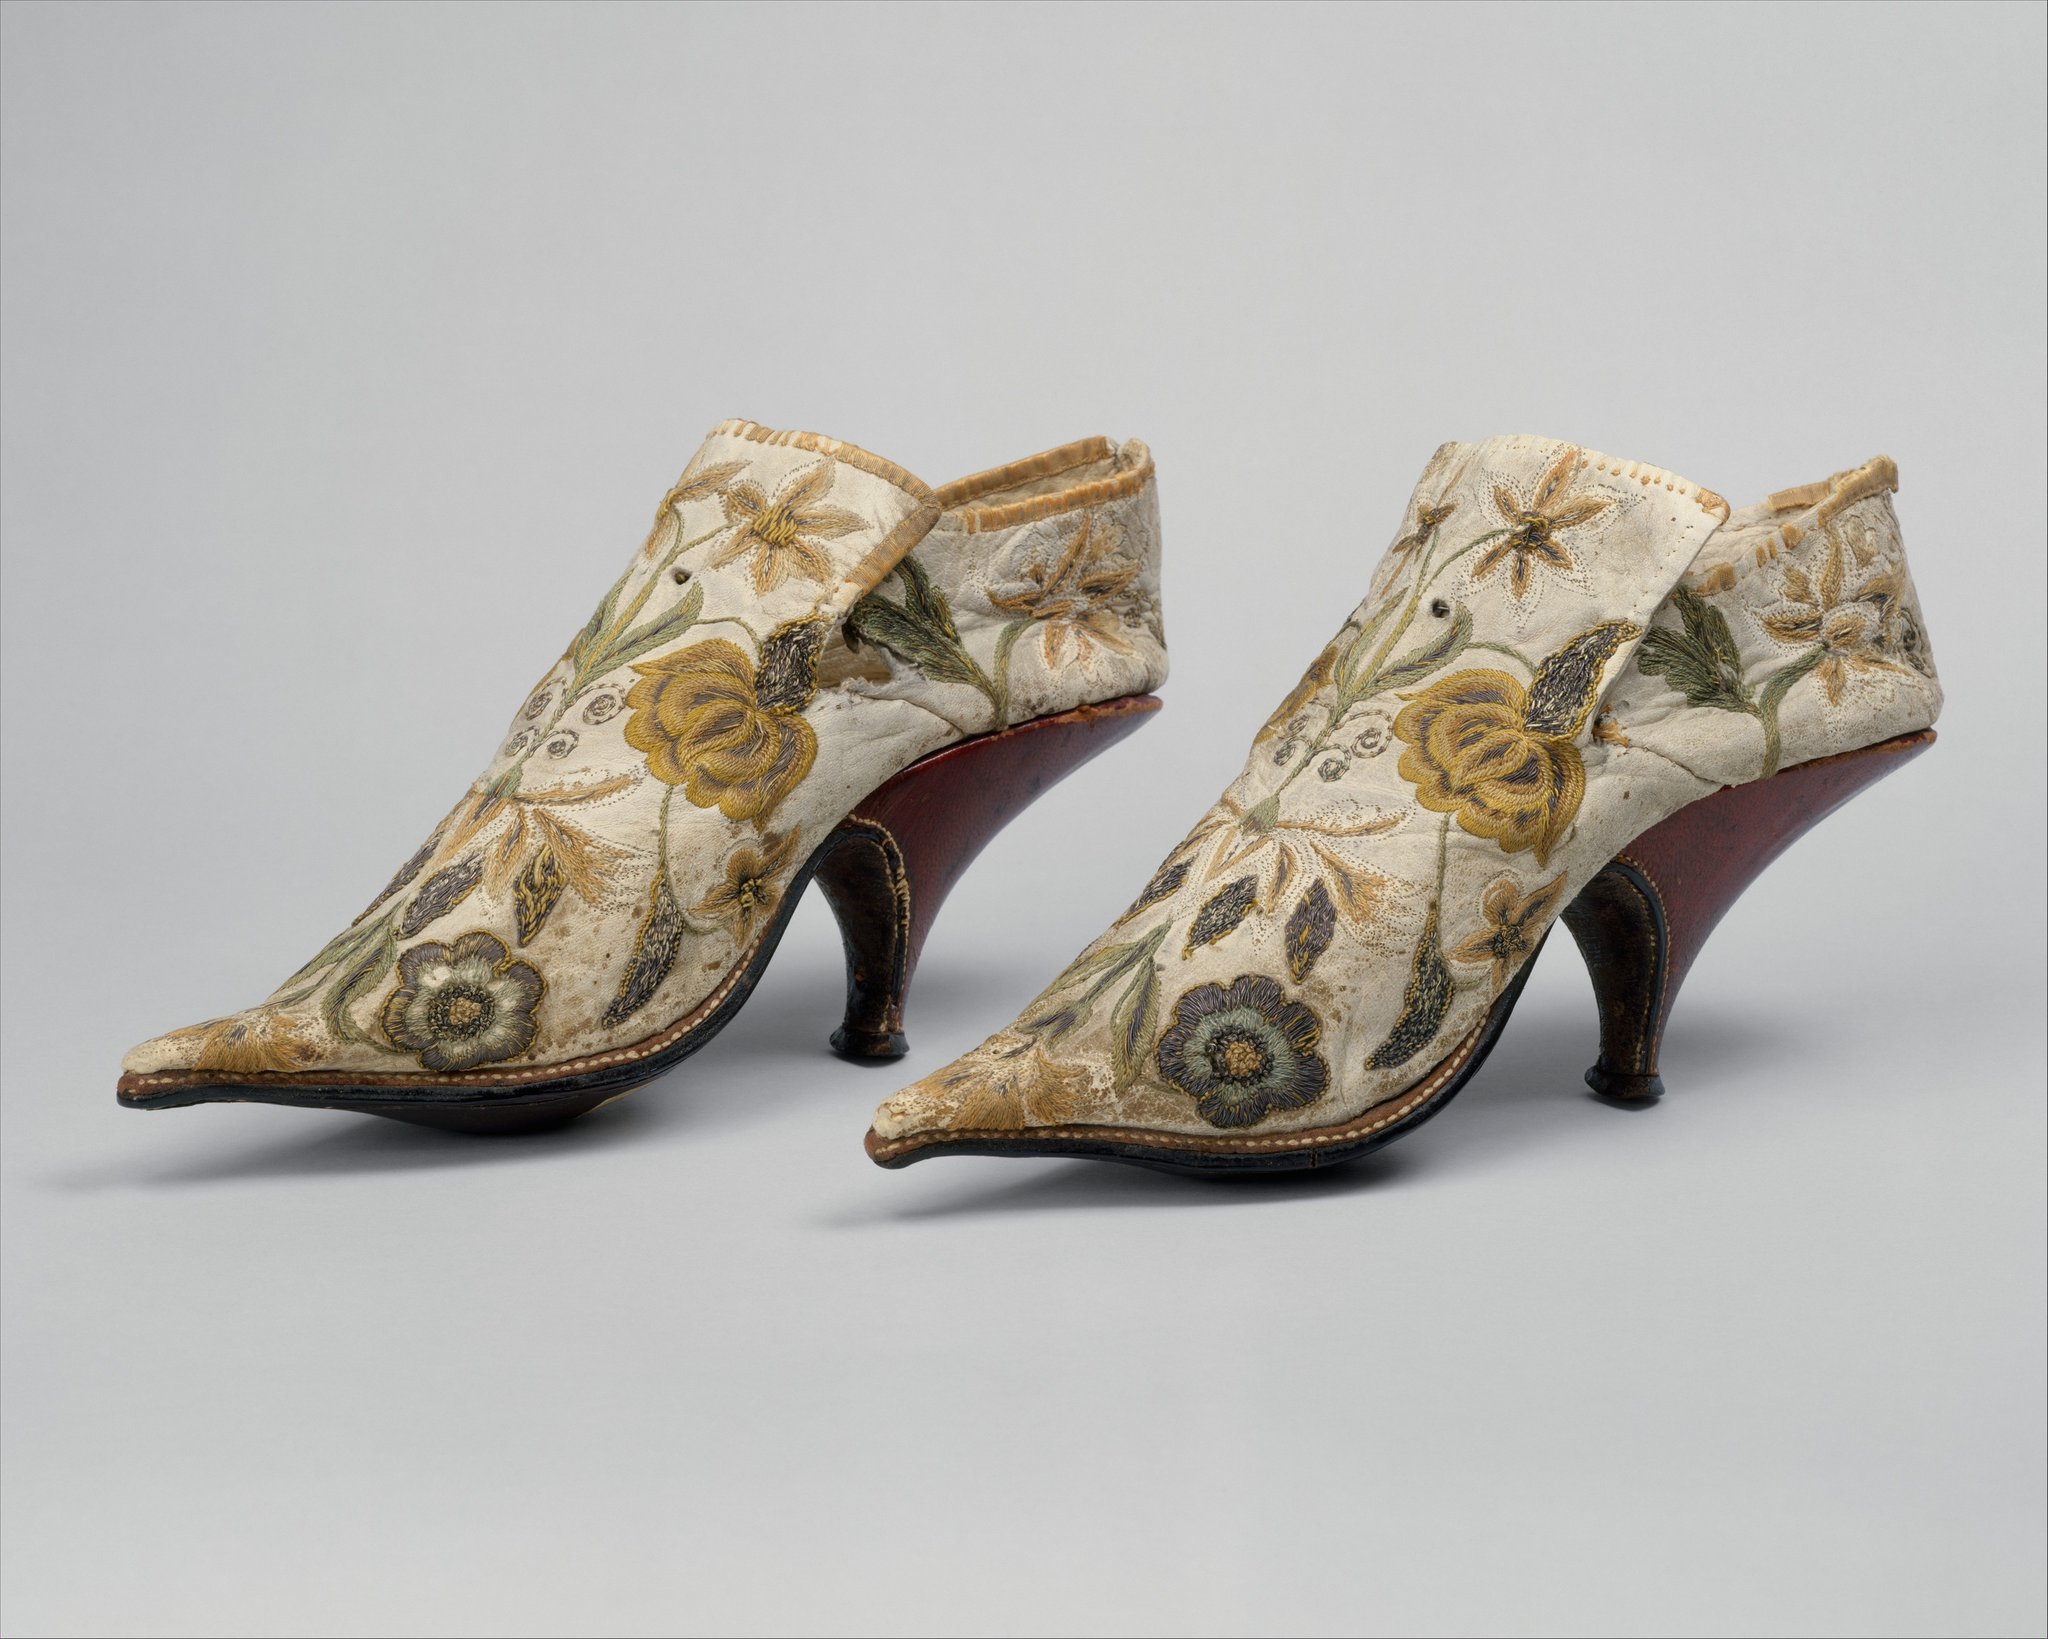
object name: shoe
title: Shoes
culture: french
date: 1690-1700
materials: leather, silk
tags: flowers